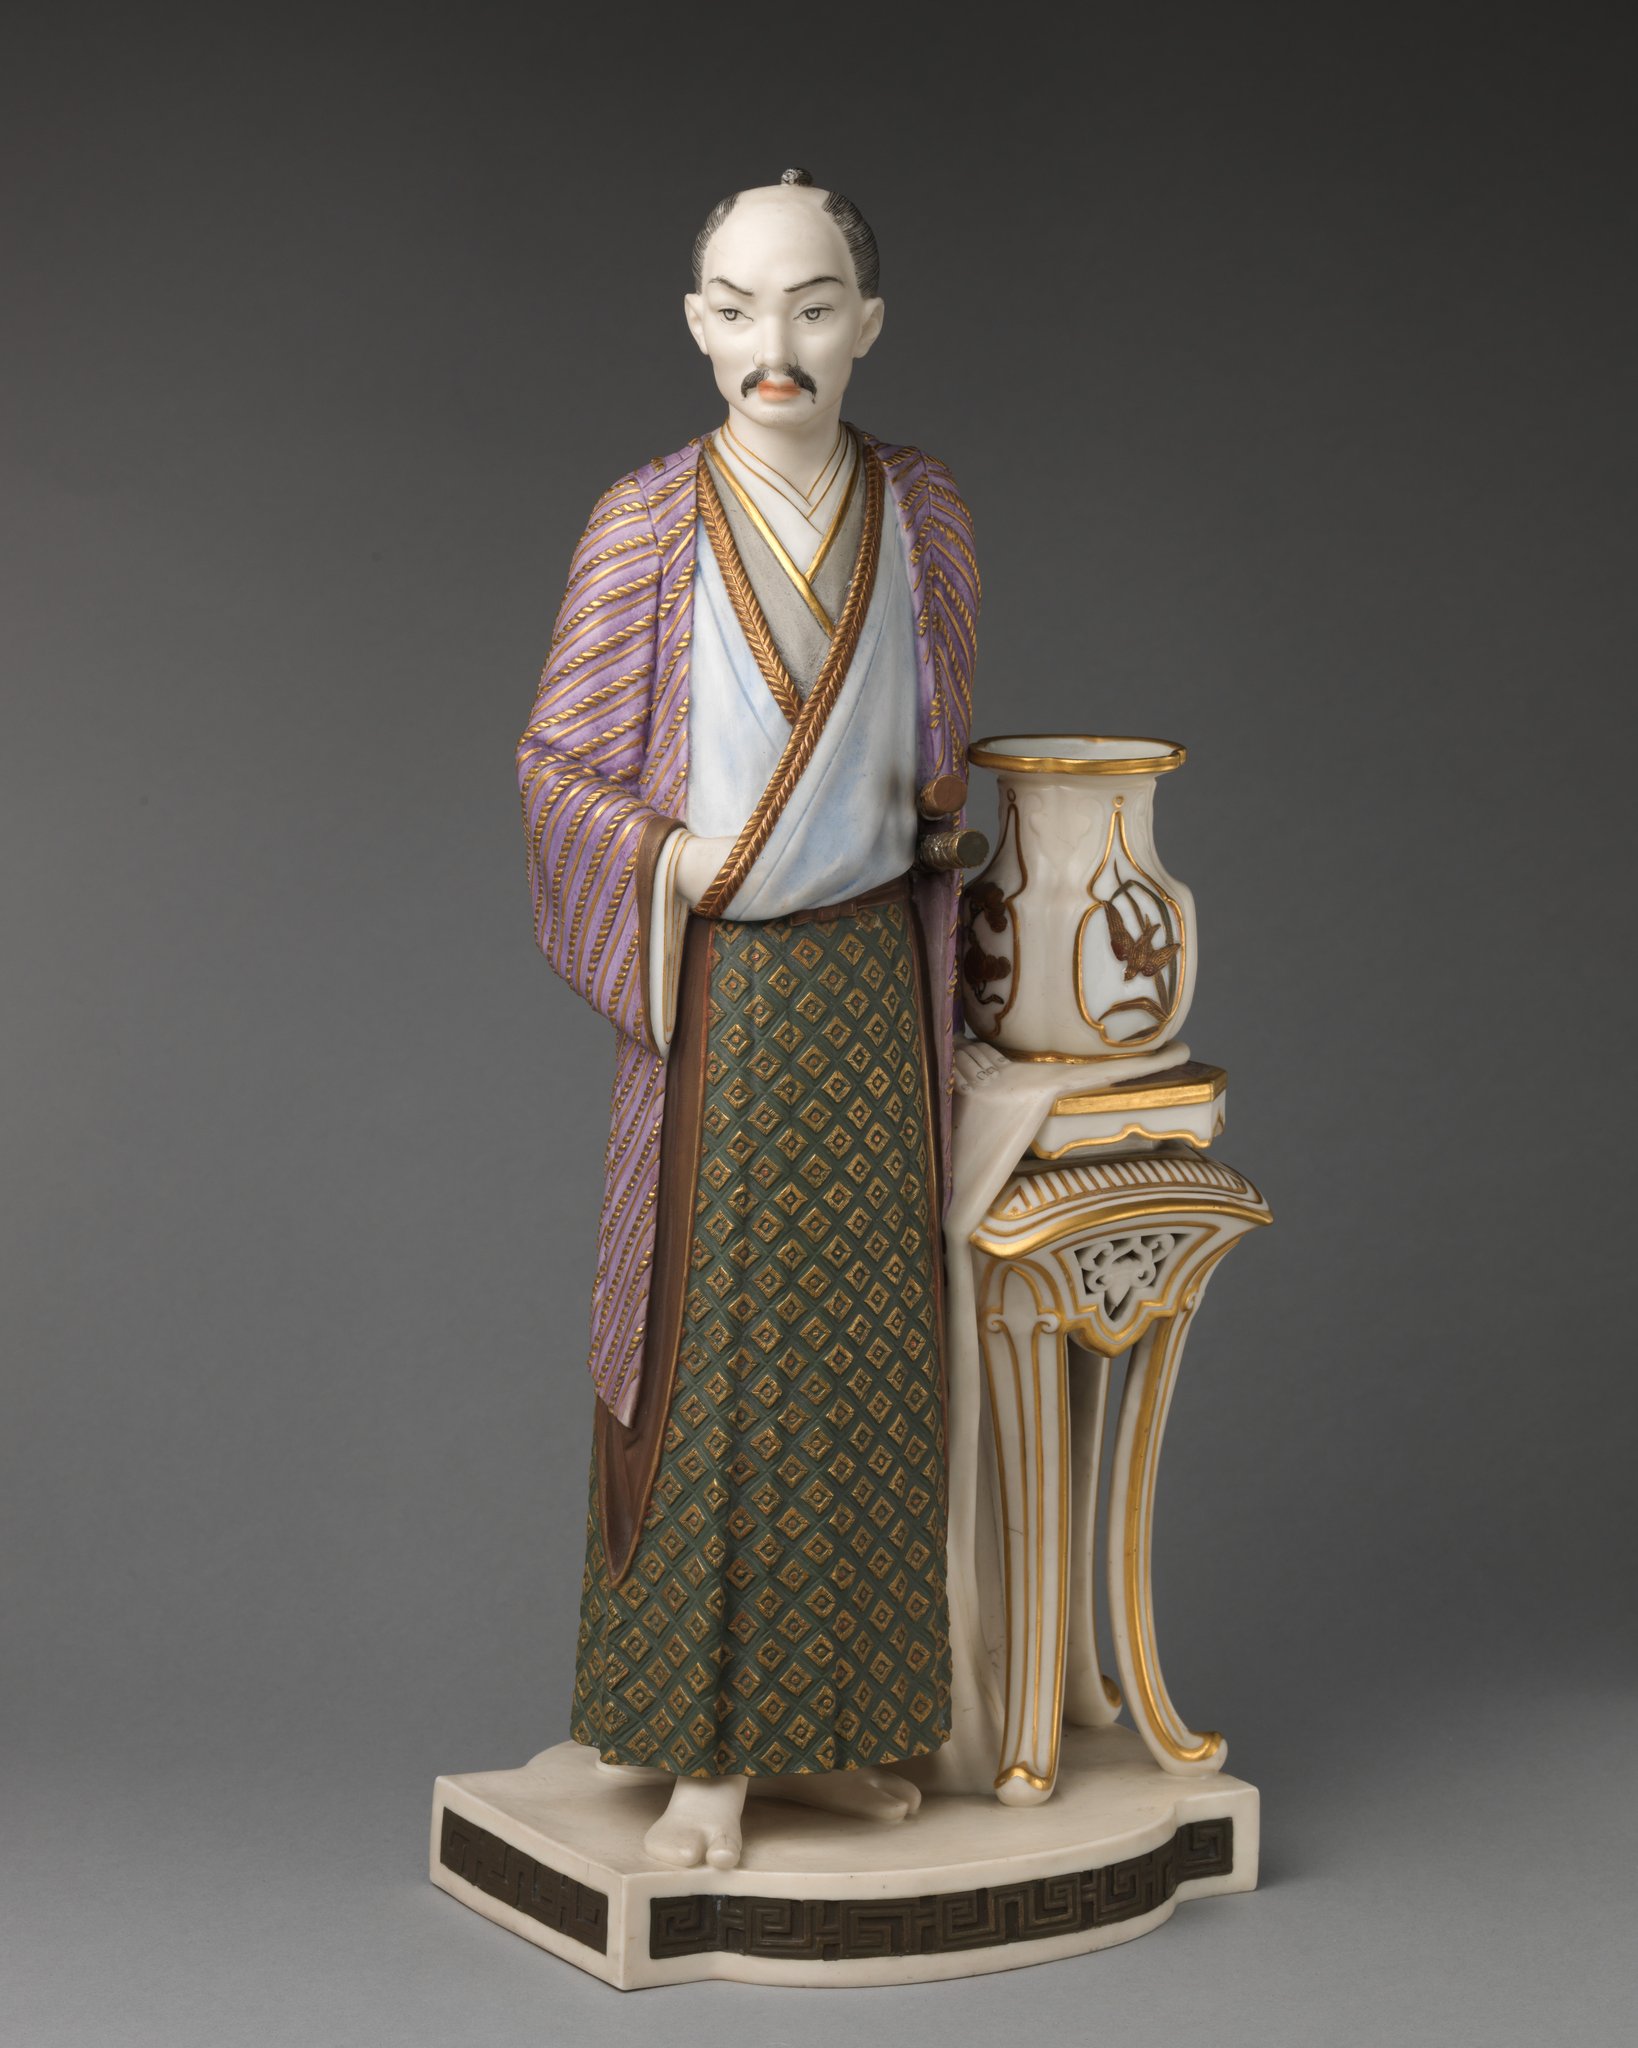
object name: figure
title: Figure of Japanese man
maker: worcester factory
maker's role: maker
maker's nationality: british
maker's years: 1751-2008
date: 1879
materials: bone china, enamel, ivory, porcelain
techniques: gilding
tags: men